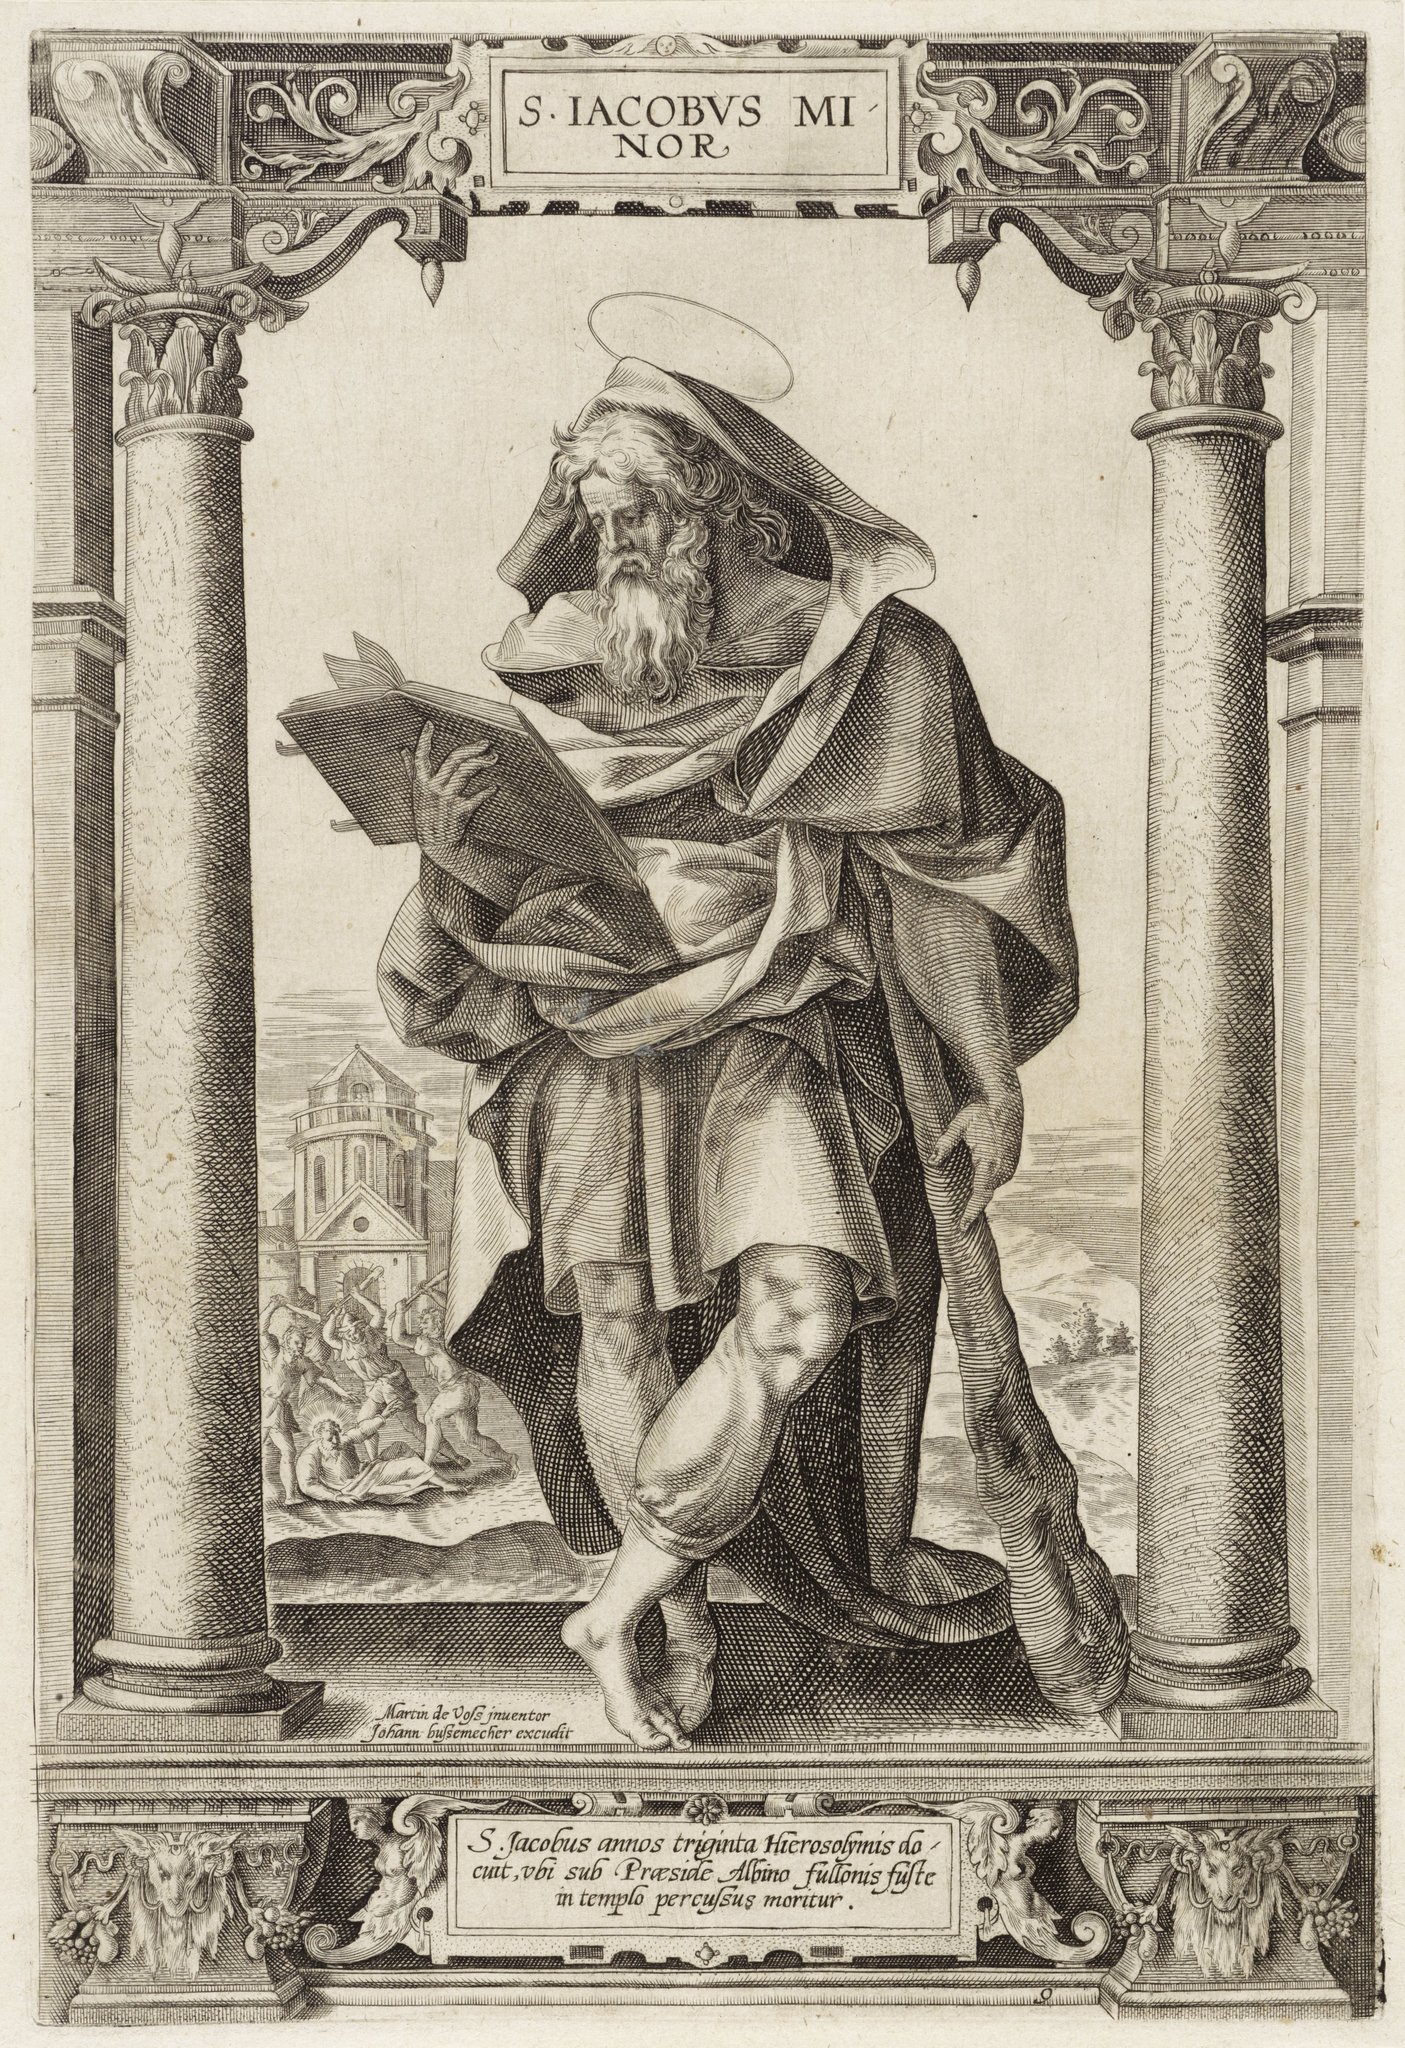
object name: print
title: Christus en de twaalf apostelen, en H. Paulus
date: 1580-1613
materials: paper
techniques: engraving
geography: antwerp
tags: column, pillar ~ architecture, the apostle james the less, first bishop of jerusalem; possible attributes: book, fuller's club, scroll, james is stoned, or beaten to death (with a fuller's club)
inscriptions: collector's mark: Lugt 240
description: De heilige Jakobus de Mindere staat tussen twee zuilen in een architecturale omlijsting. Hij leest in een boek dat hij in zijn hand houdt. Met zijn andere hand leunt hij tegen een voldersknuppel. Op de achtergrond is te zien hoe mannen met voldersknuppels op het hoofd van Jakobus slaan. In het kader onderaan een drieregelig onderschrift in het Latijn.